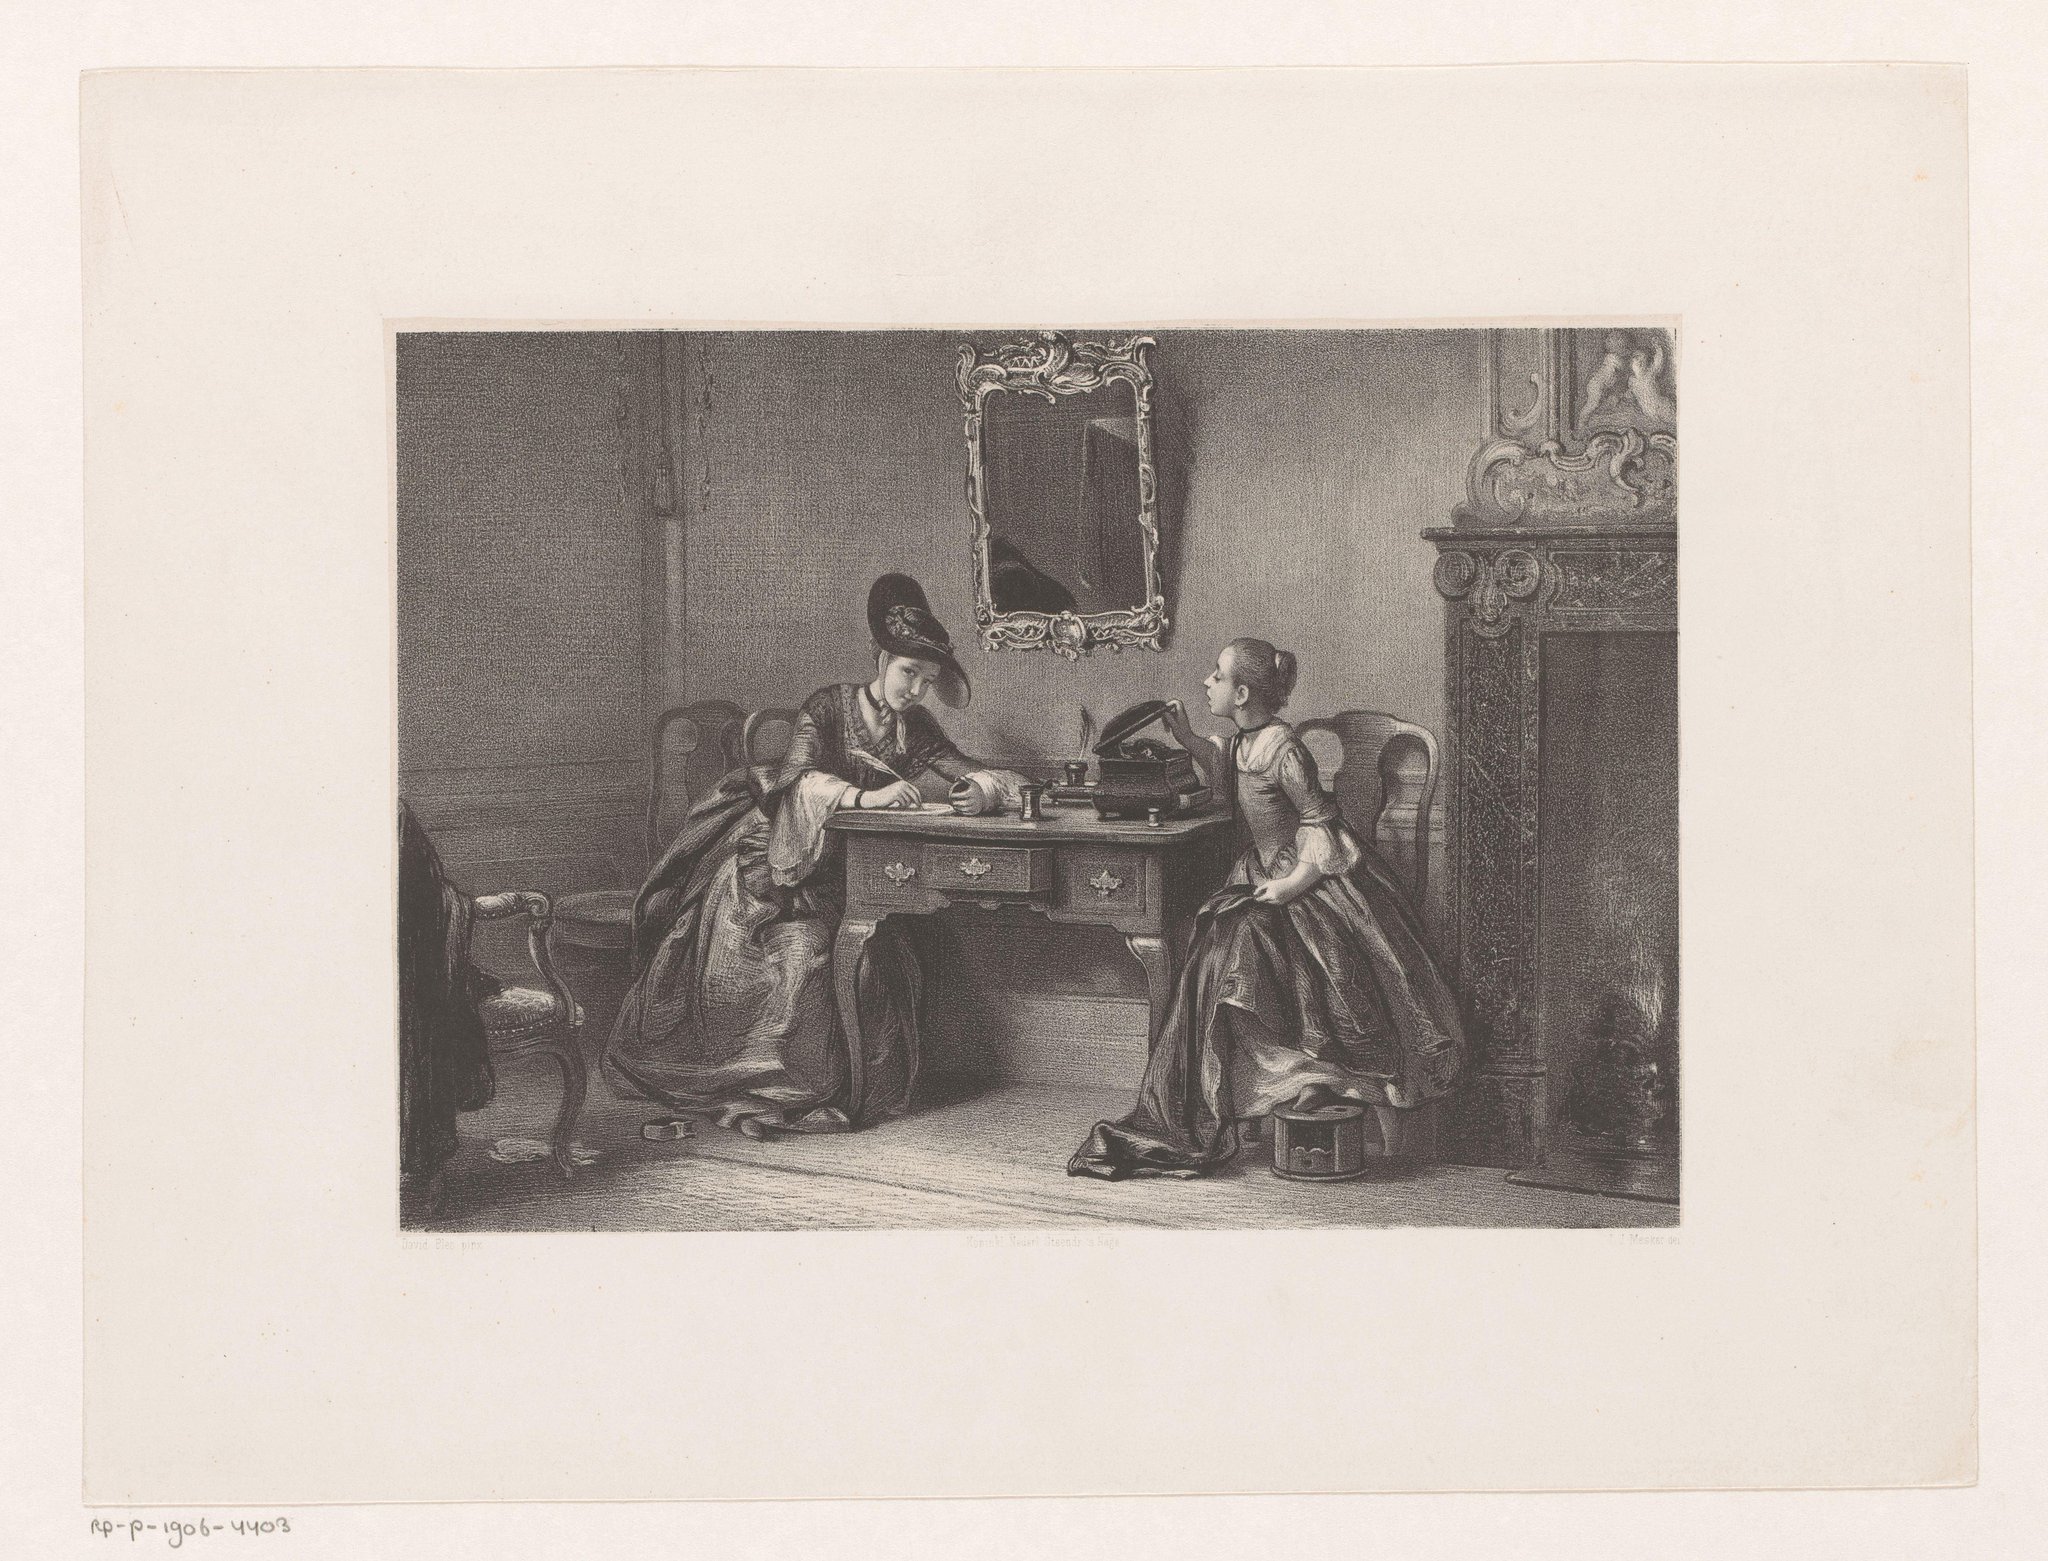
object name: print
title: Twee jonge vrouwen aan een console tafel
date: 1867-1874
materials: paper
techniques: lithograph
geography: the hague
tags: handwriting, writing as activity, foot-stove, open hearth, fire-place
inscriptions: collector's mark: Lugt 2228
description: Een vrouw draagt een hoed en schrijft een brief. De andere vrouw tilt het deksel van een kist. Haar voeten rusten op een voetenstoof. Rechts van hen een open haard.